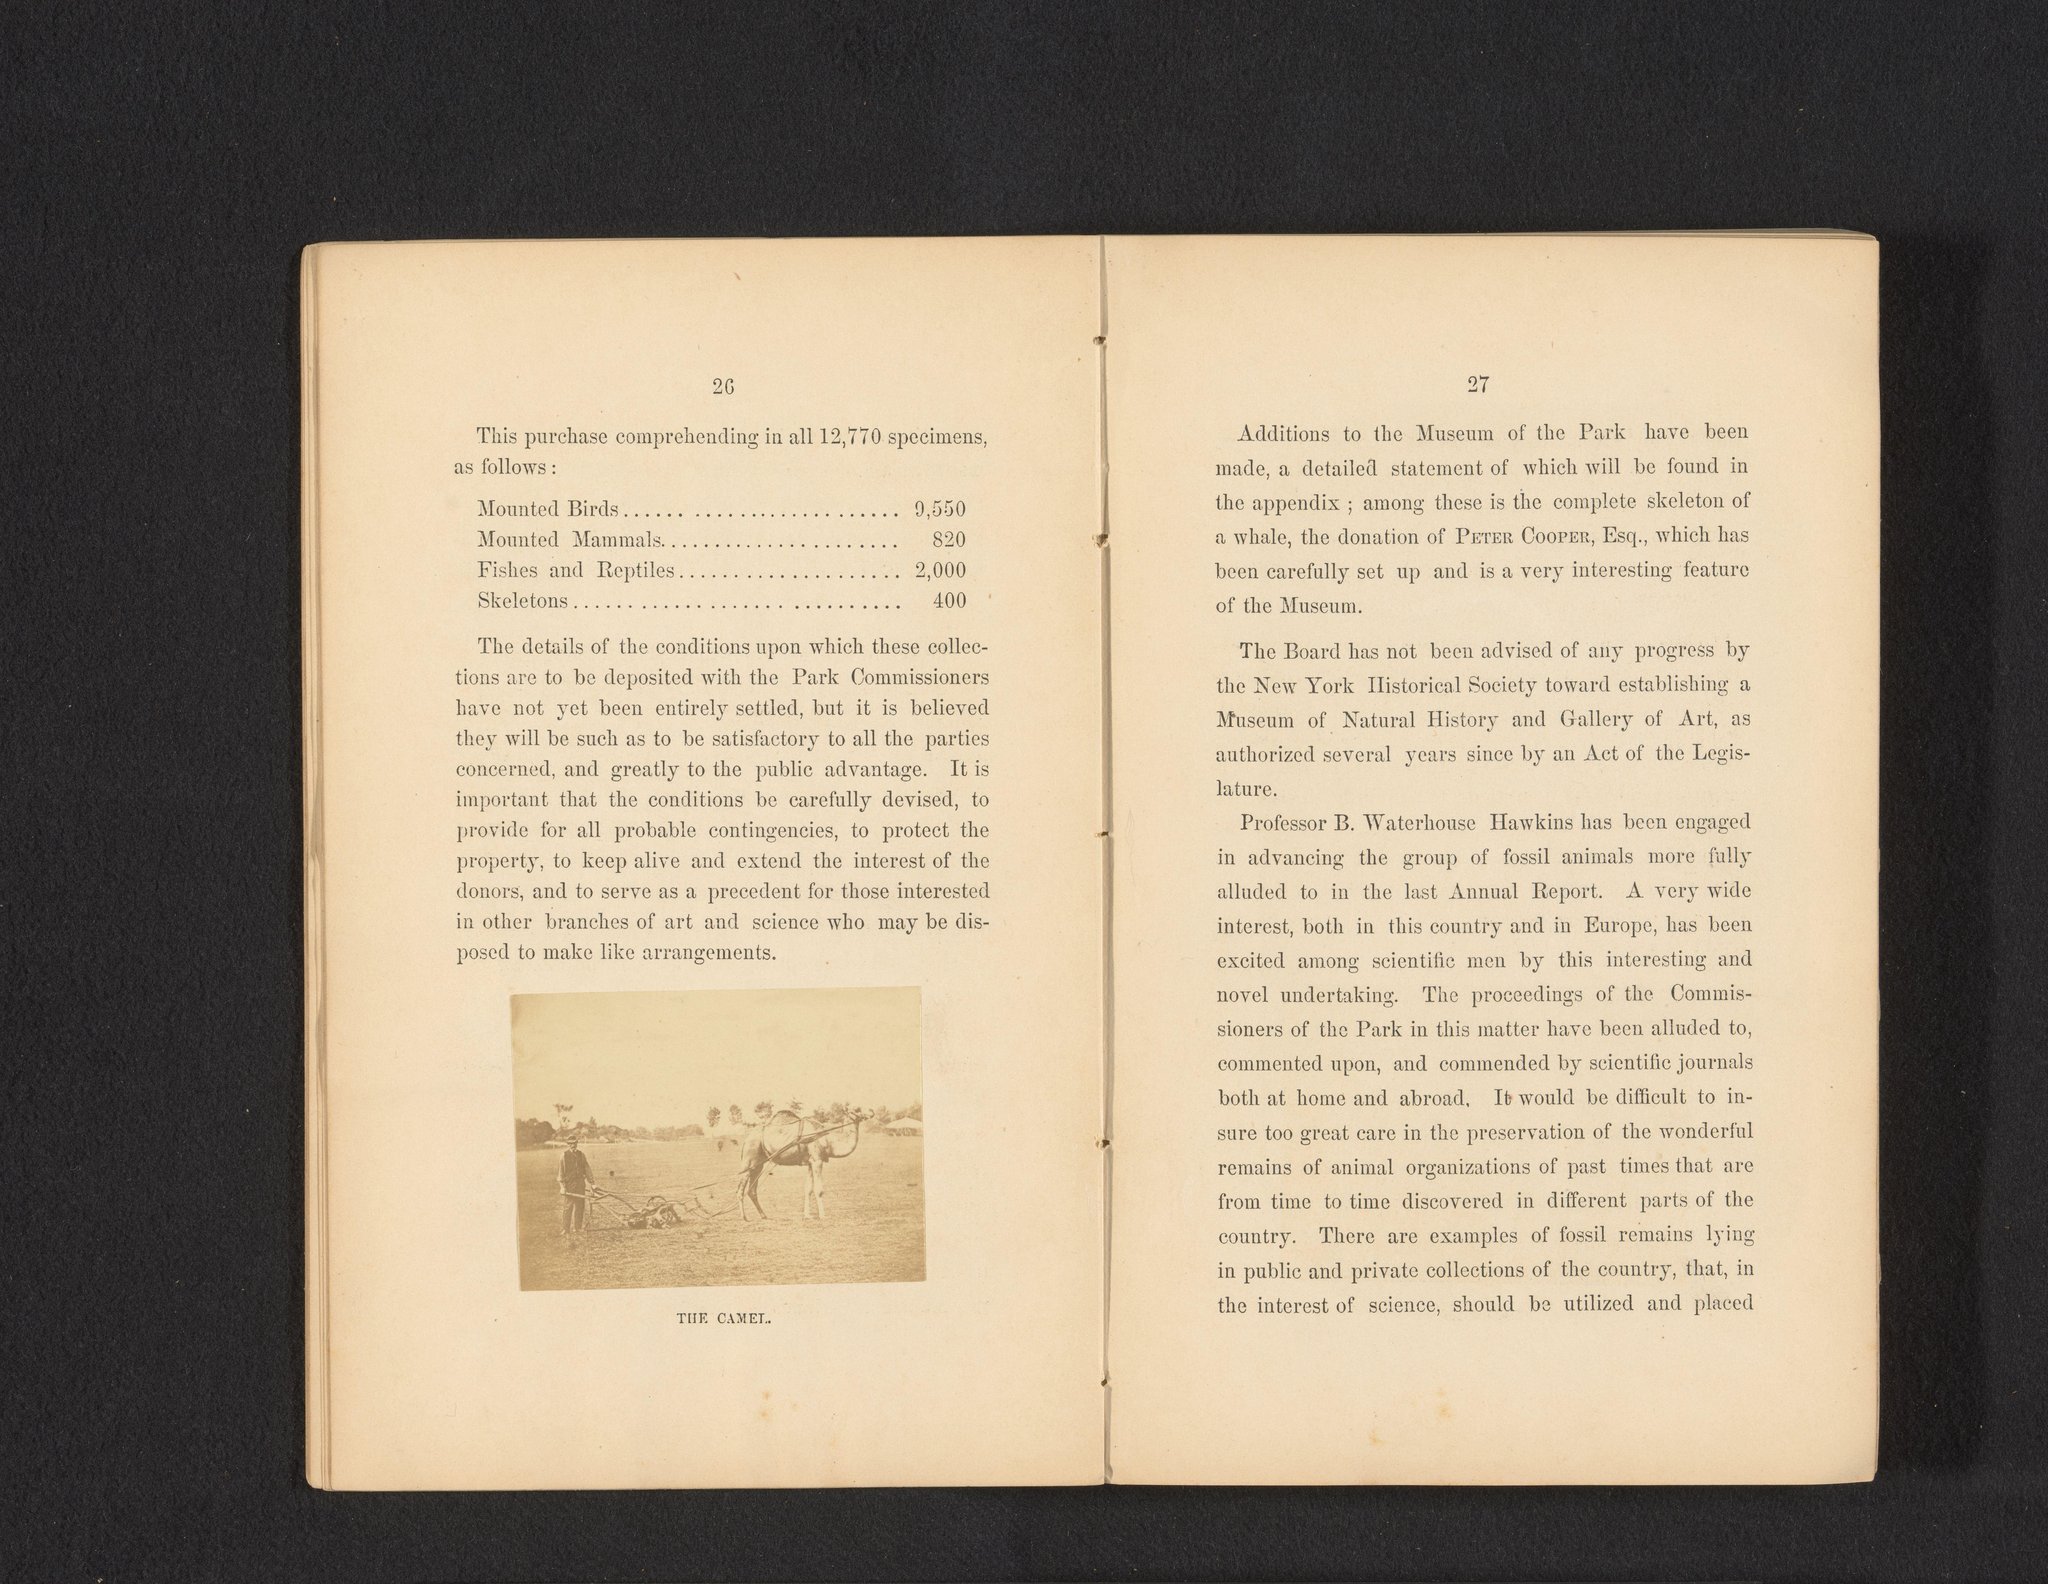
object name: page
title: The camel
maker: george gardner rockwood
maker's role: fotograaf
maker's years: 1832-1911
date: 1869-1870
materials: photographic support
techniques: albumen print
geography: central park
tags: hoofed animals: camel, agricultural implements: plough